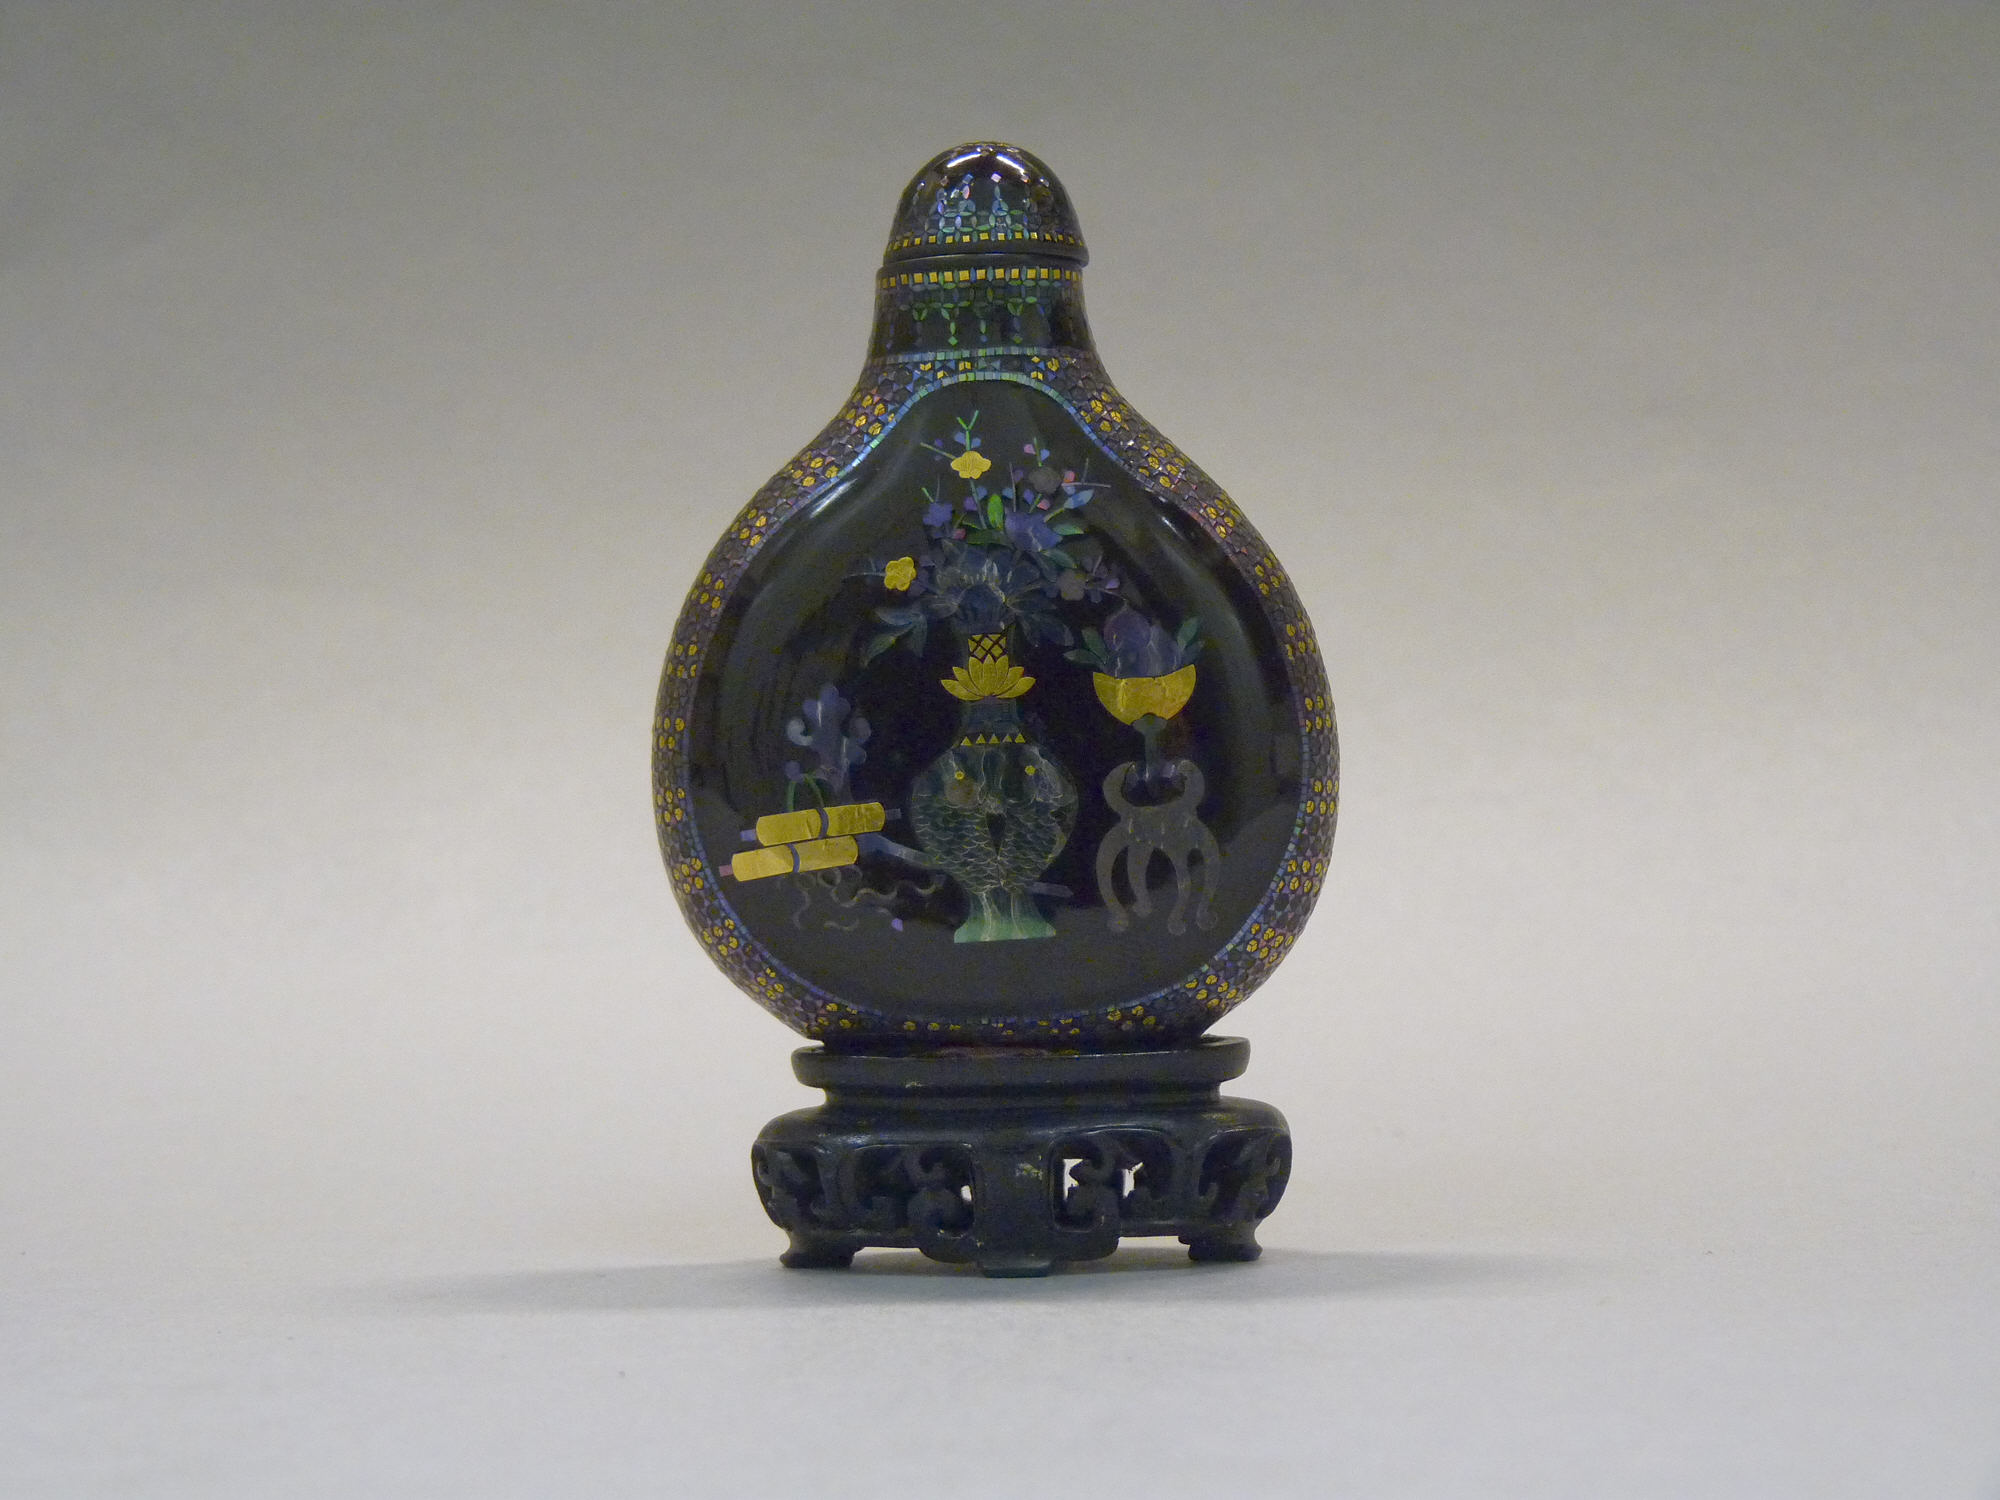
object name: snuff bottle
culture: chinese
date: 1736-1795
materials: lacquer, mother of pearl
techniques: inlay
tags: fish,flowers